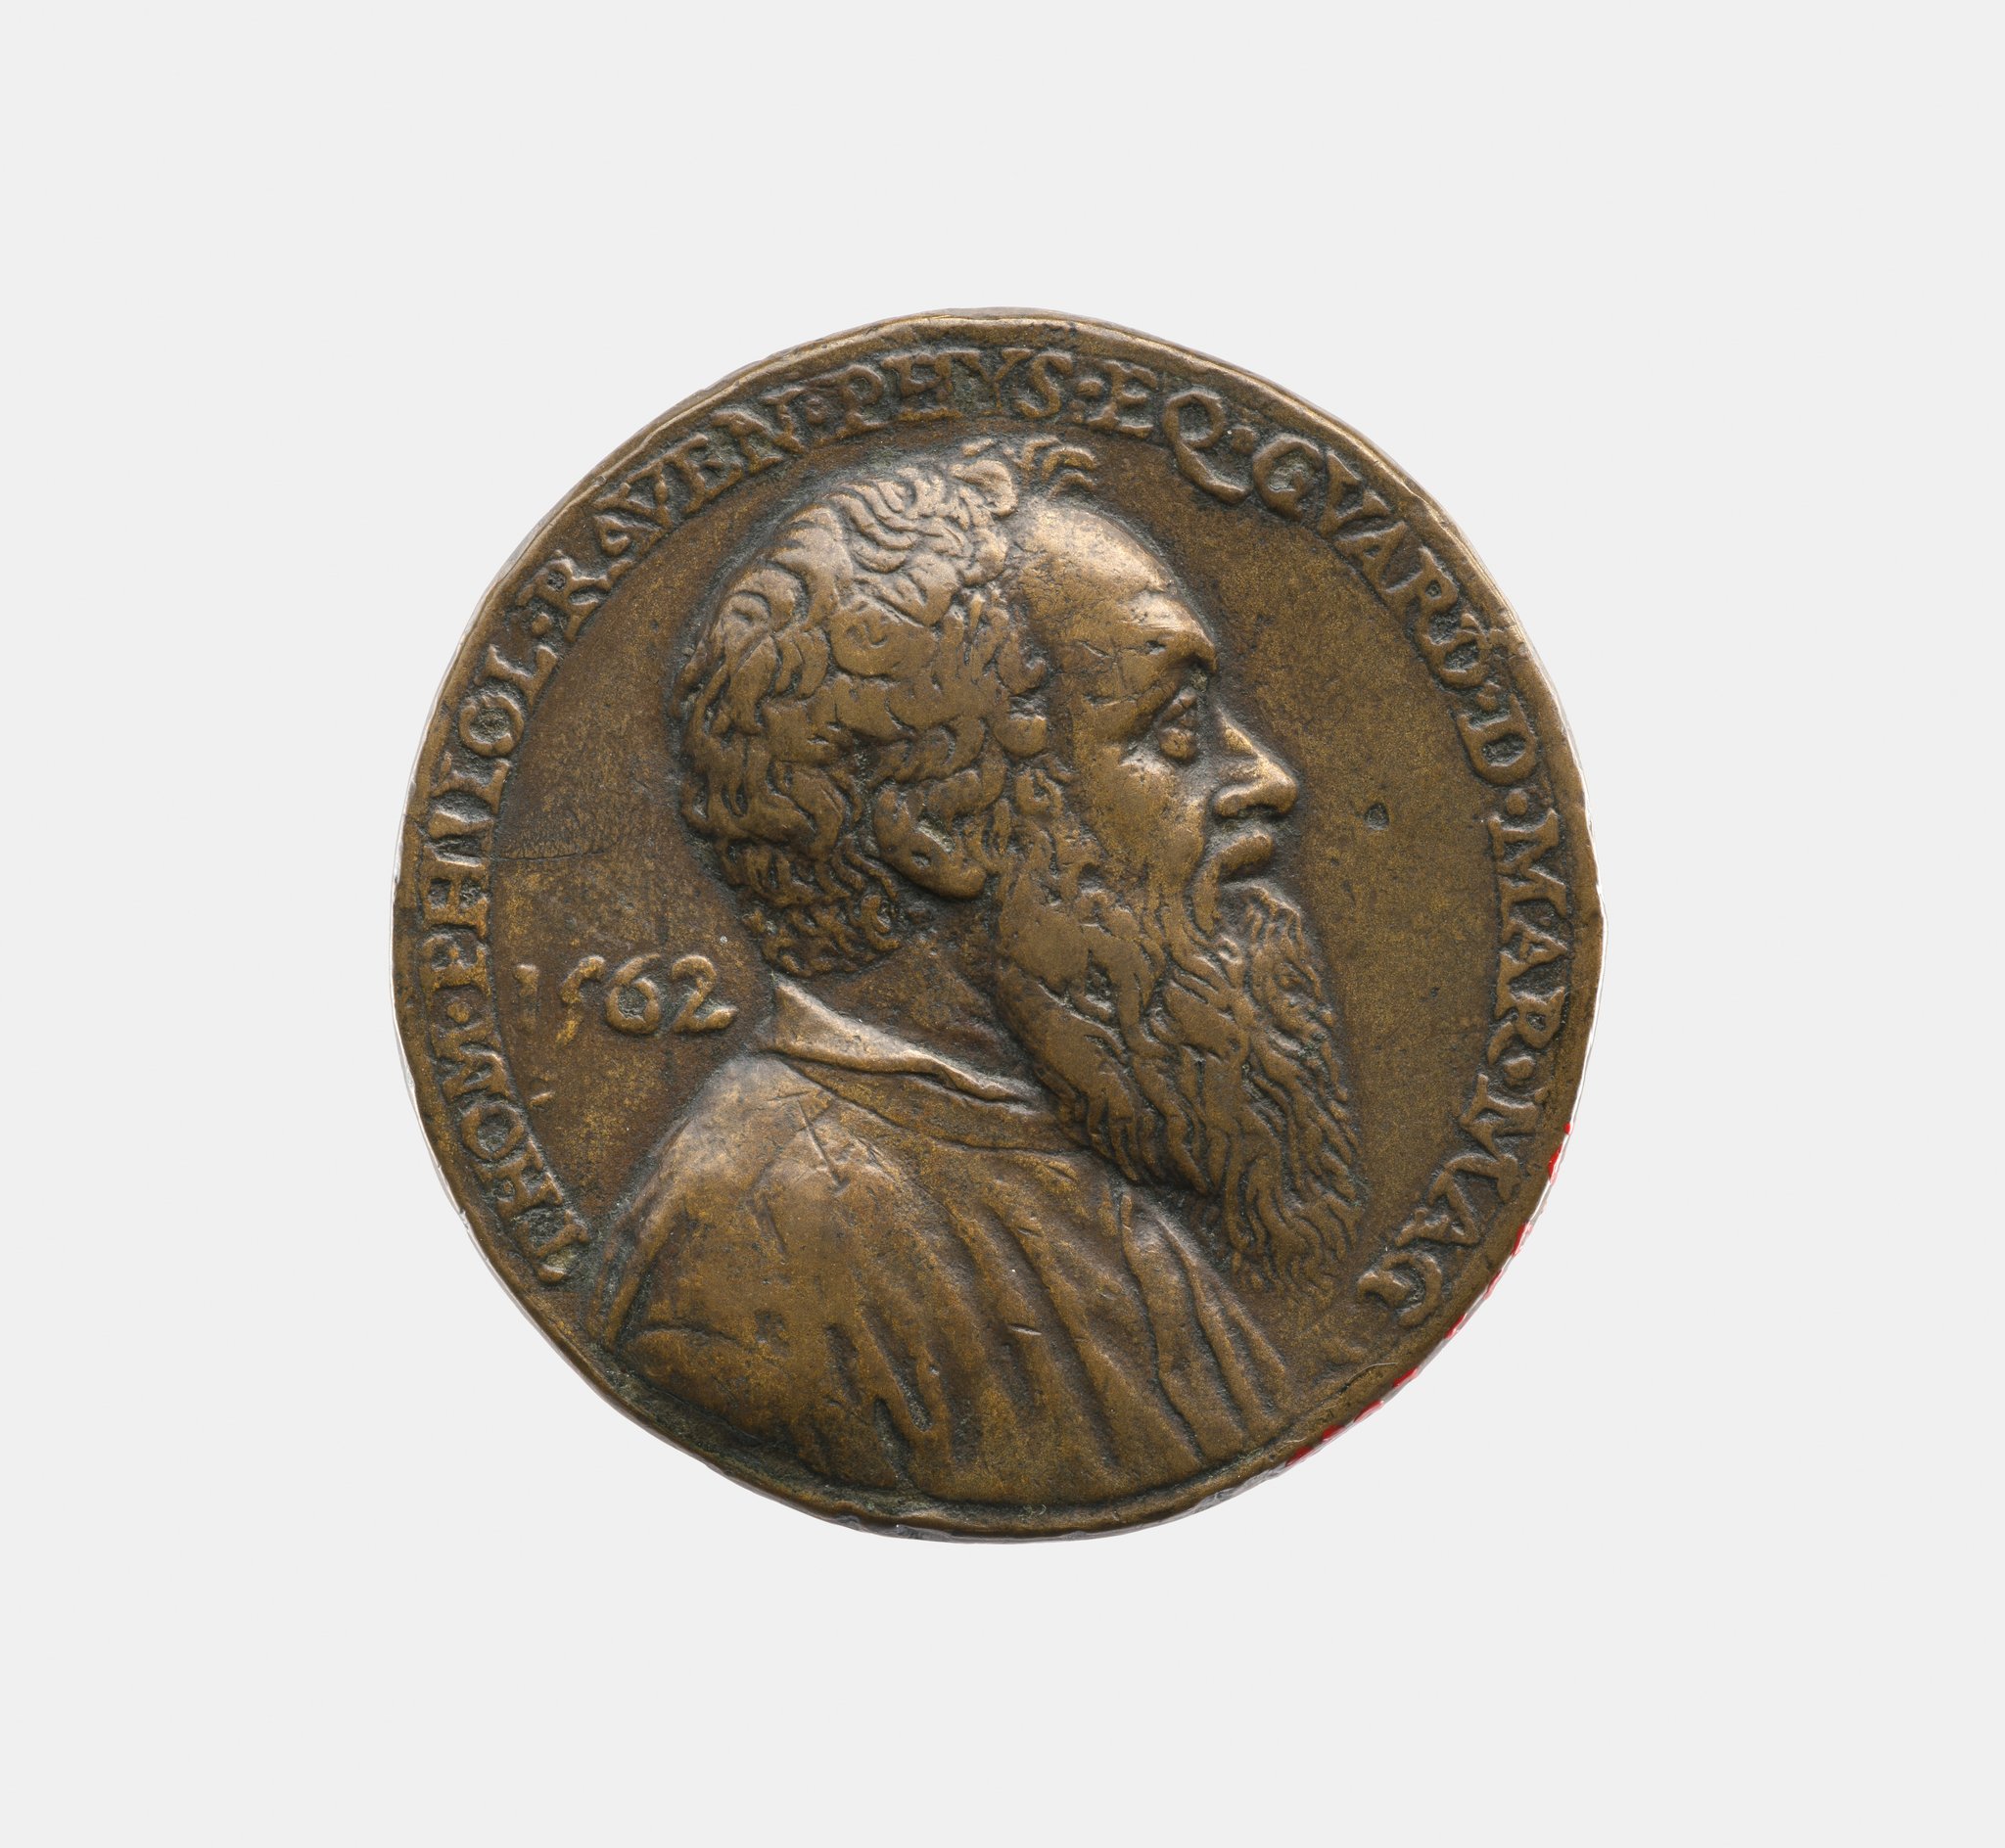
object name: medal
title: Tommaso Rangoni 1493-1577, professor in Padua, physician in Venice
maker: alessandro vittoria (alessandro vittoria di vigilio della volpa)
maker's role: artist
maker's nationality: italian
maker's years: 1525-1608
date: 1562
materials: bronze